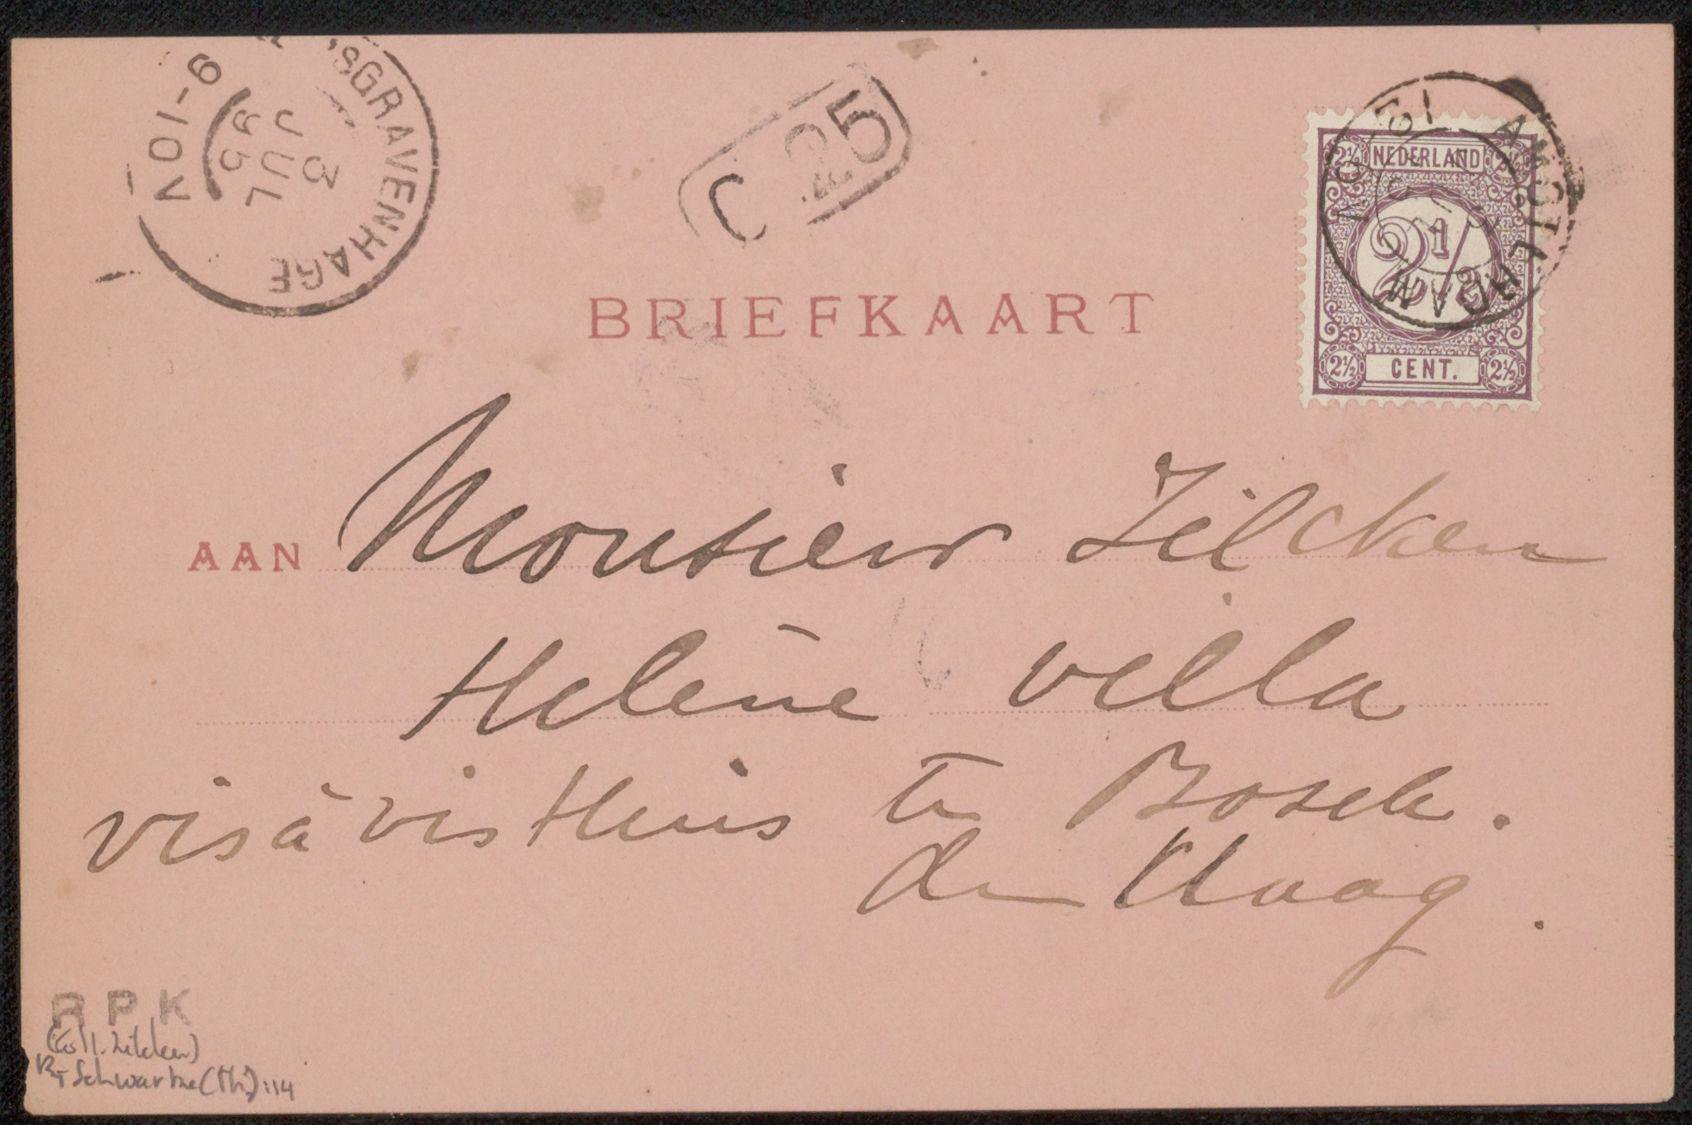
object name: postcard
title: Briefkaart aan Philip Zilcken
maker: thérèse schwartze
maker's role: draughtsman, painter, print maker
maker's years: 1851-1918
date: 1895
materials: cardboard, ink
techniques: pen, writing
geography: amsterdam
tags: voorburg, print maker, renée hélène laure zilcken, painter, draughtsman, philip zilcken, historical persons (portraits and scenes from the life)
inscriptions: collector's mark: ‘RPK’